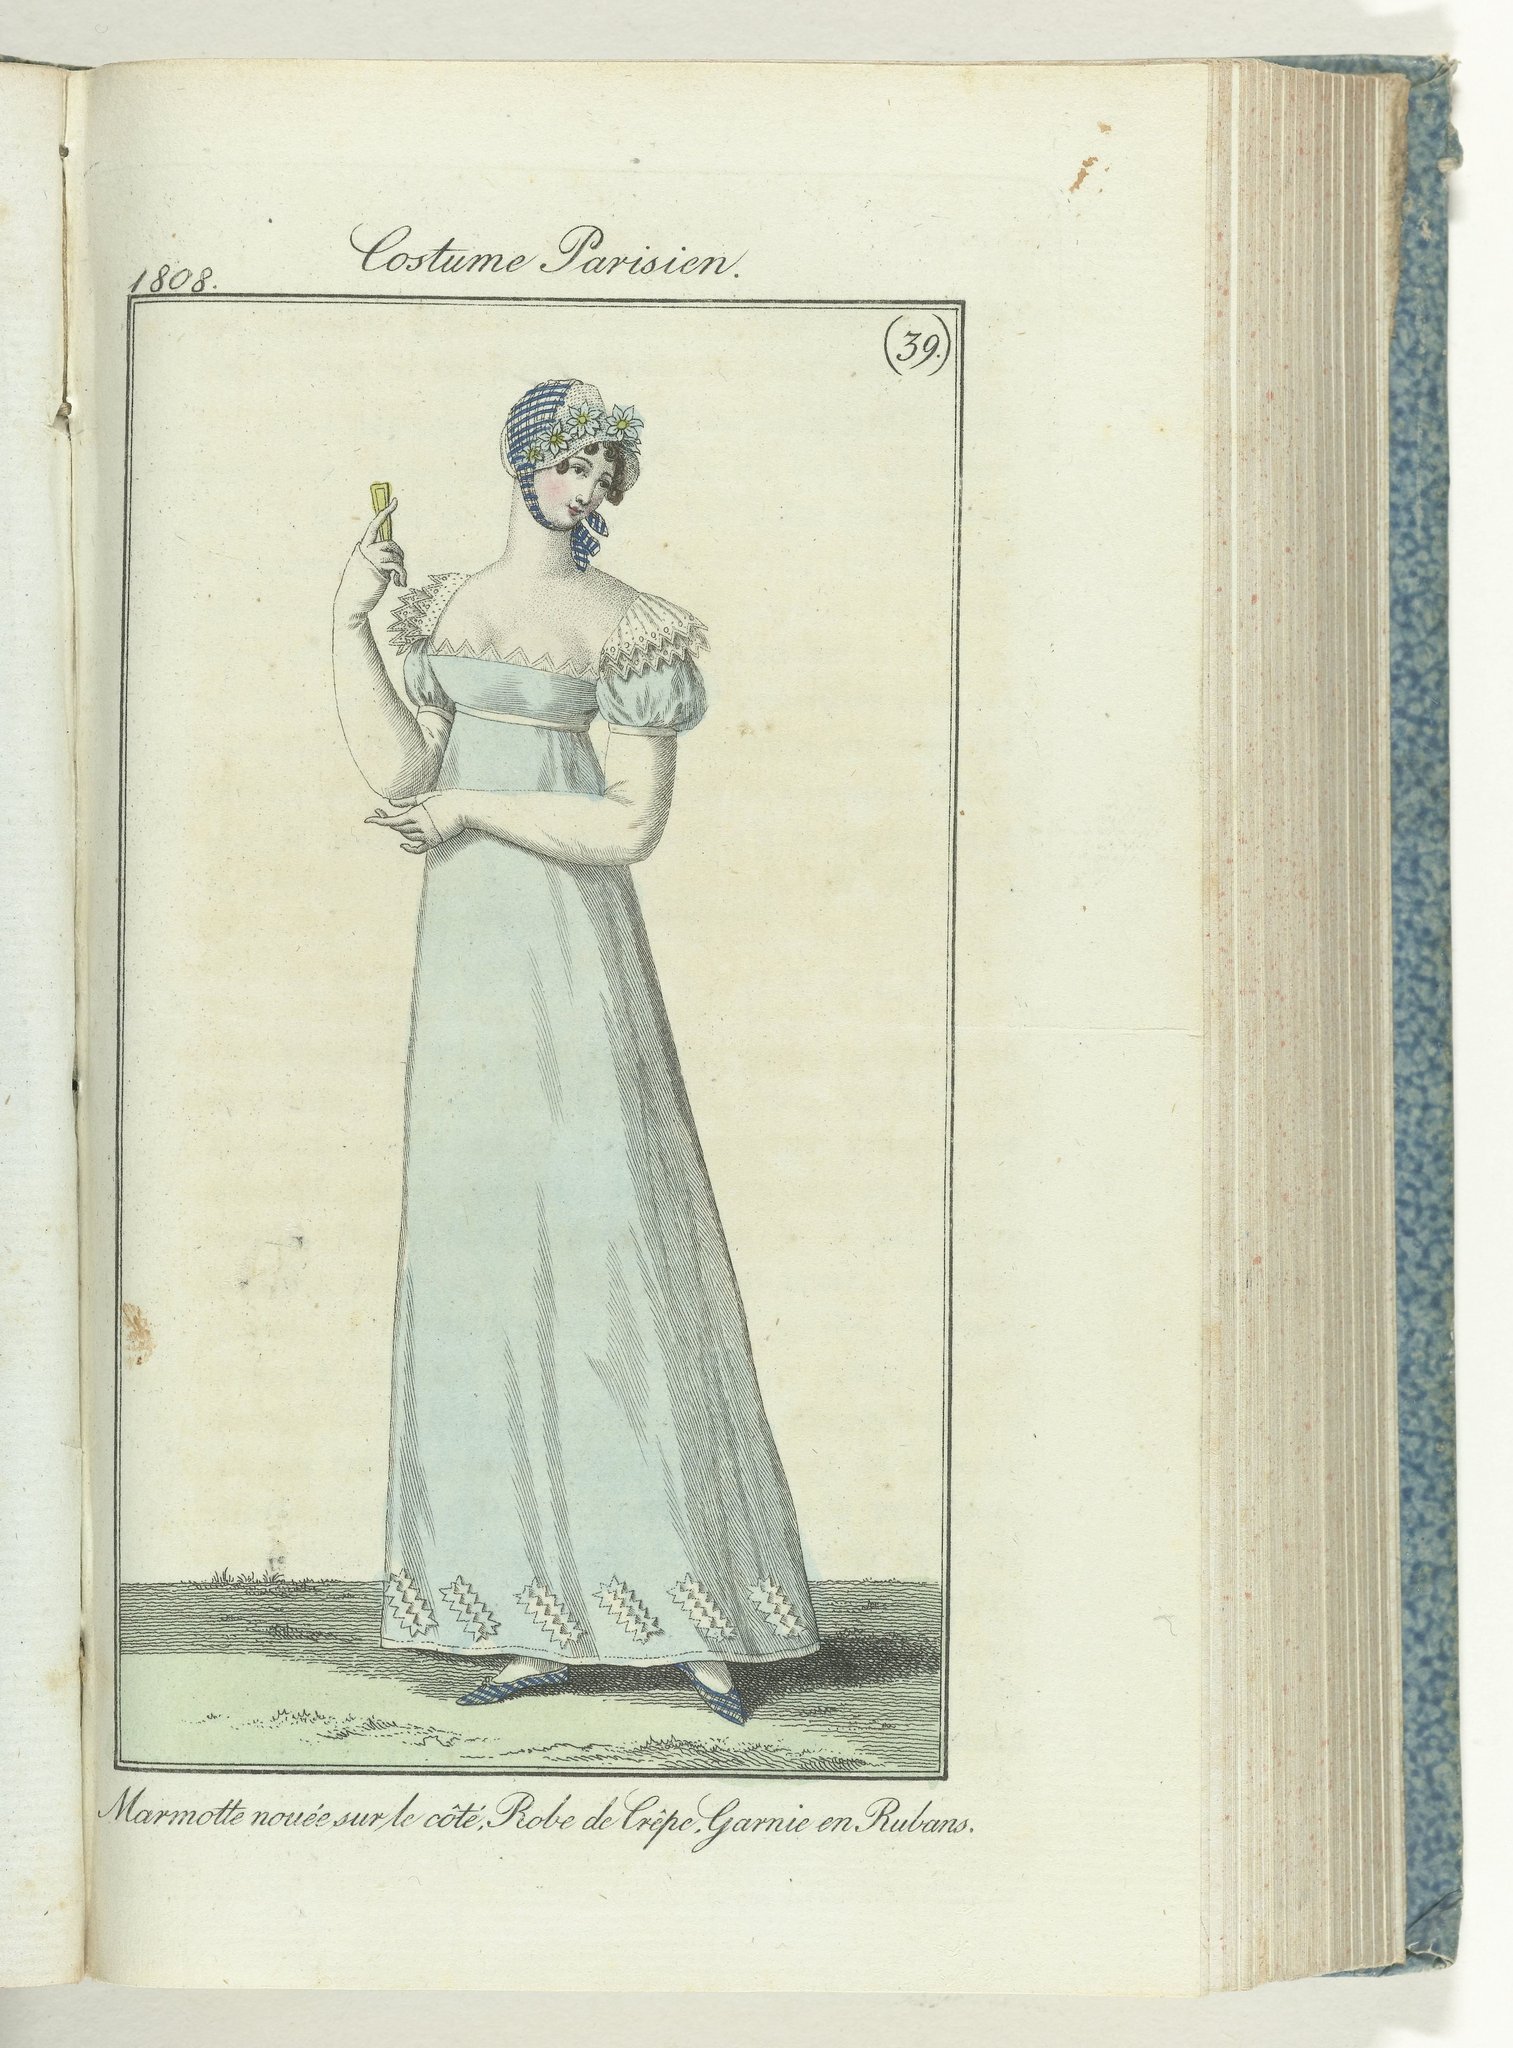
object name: magazine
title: Journal des Dames et des Modes, editie Frankfurt 25 septembre 1808, Costume Parisien (39): Marmotte nouée sur le côté, Robe de Crêpe, Garnie en Rubans.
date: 1808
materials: paper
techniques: engraving, hand coloring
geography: frankfurt am main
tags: gloves, mittens (mitaines) (+ women's clothes), head-gear (headscarf) (+ women's clothes), fashion plates, shoes, sandals (+ women's clothes), dress, gown (+ women's clothes), fan (+ women's clothes)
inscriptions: caption: ‘Marmotte nouée sur le côté, Robe de Crêpe, Garnie en Rubans.’, title: ‘Costume Parisien.’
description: De begeleidende tekst (p. 342) vermeldt: 'Marmotte' (bepaald soort hoofddoekje), aan de zijkant geknoopt en versierd met een rand van bloemetjes. Japon van crêpe met linten. Mouwen afgezet met linten. Witte mitaines. Blauwe schoenen. De prent maakt deel uit van het modetijdschrift Journal des Dames et des Modes, uitgegeven in Frankfurt als kopie van de Franse editie van Pierre de la Mésangère, (1798-1848).